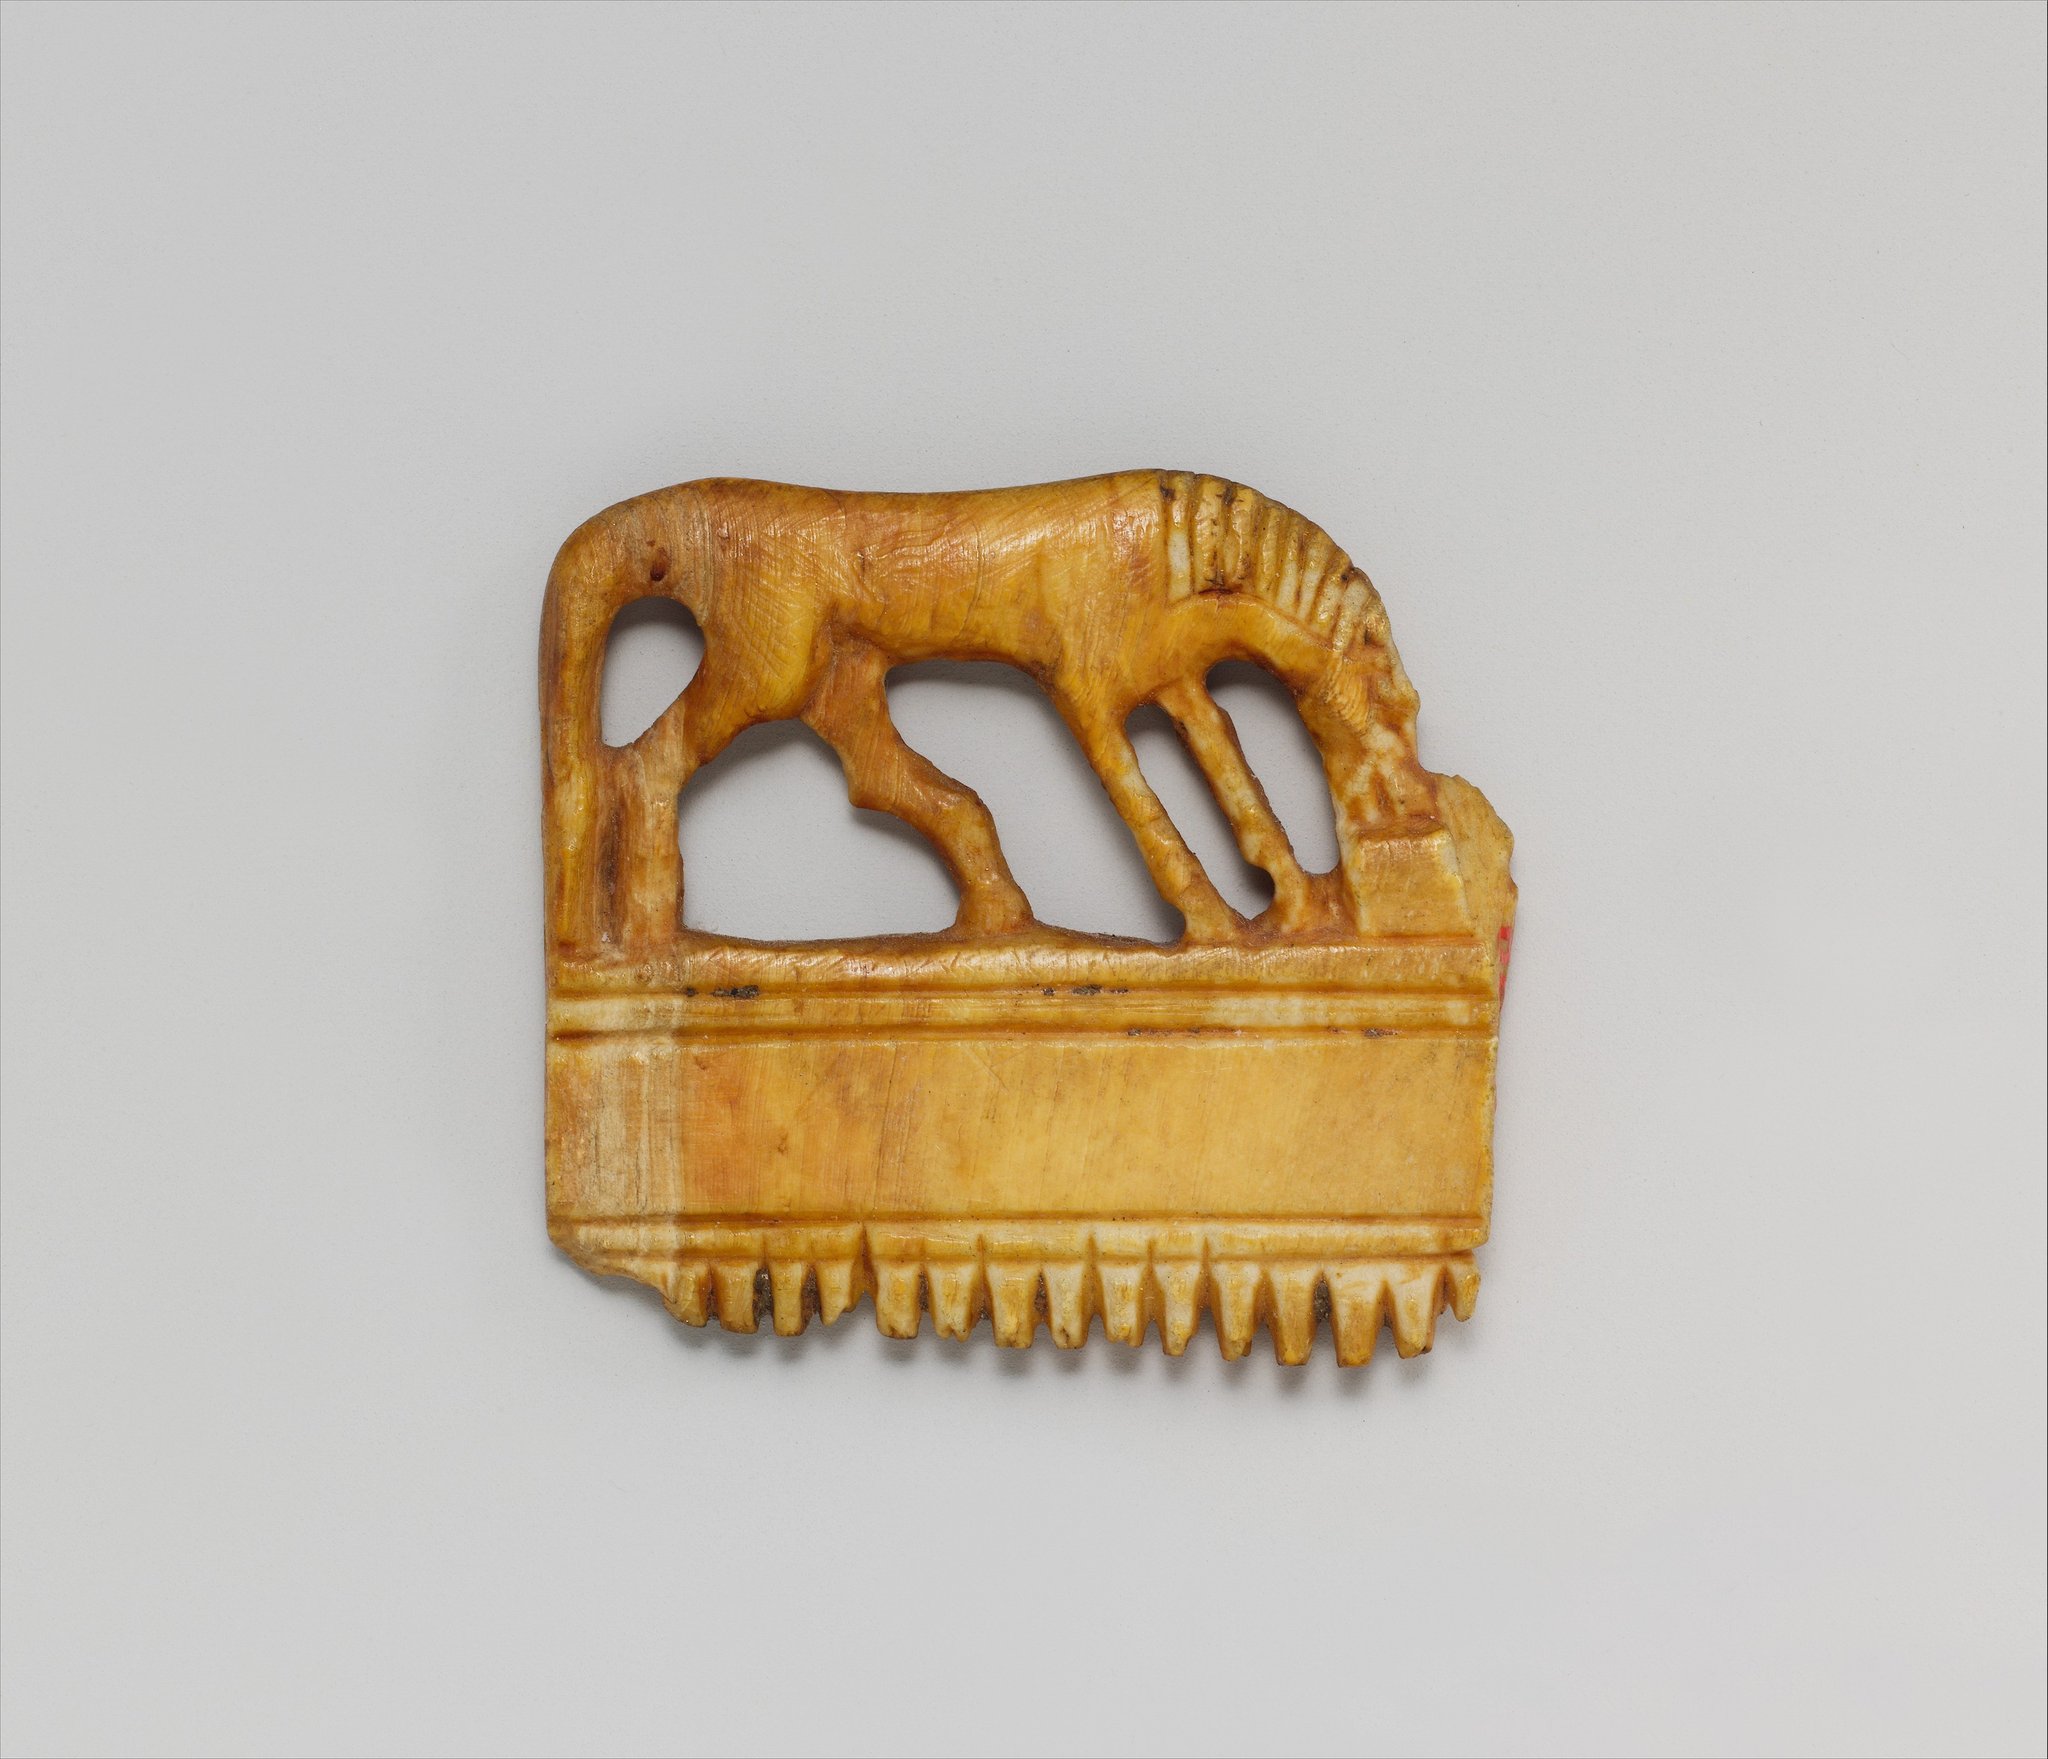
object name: comb, horse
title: Comb with a horse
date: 1295-1186 BCE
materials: ivory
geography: egypt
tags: horses